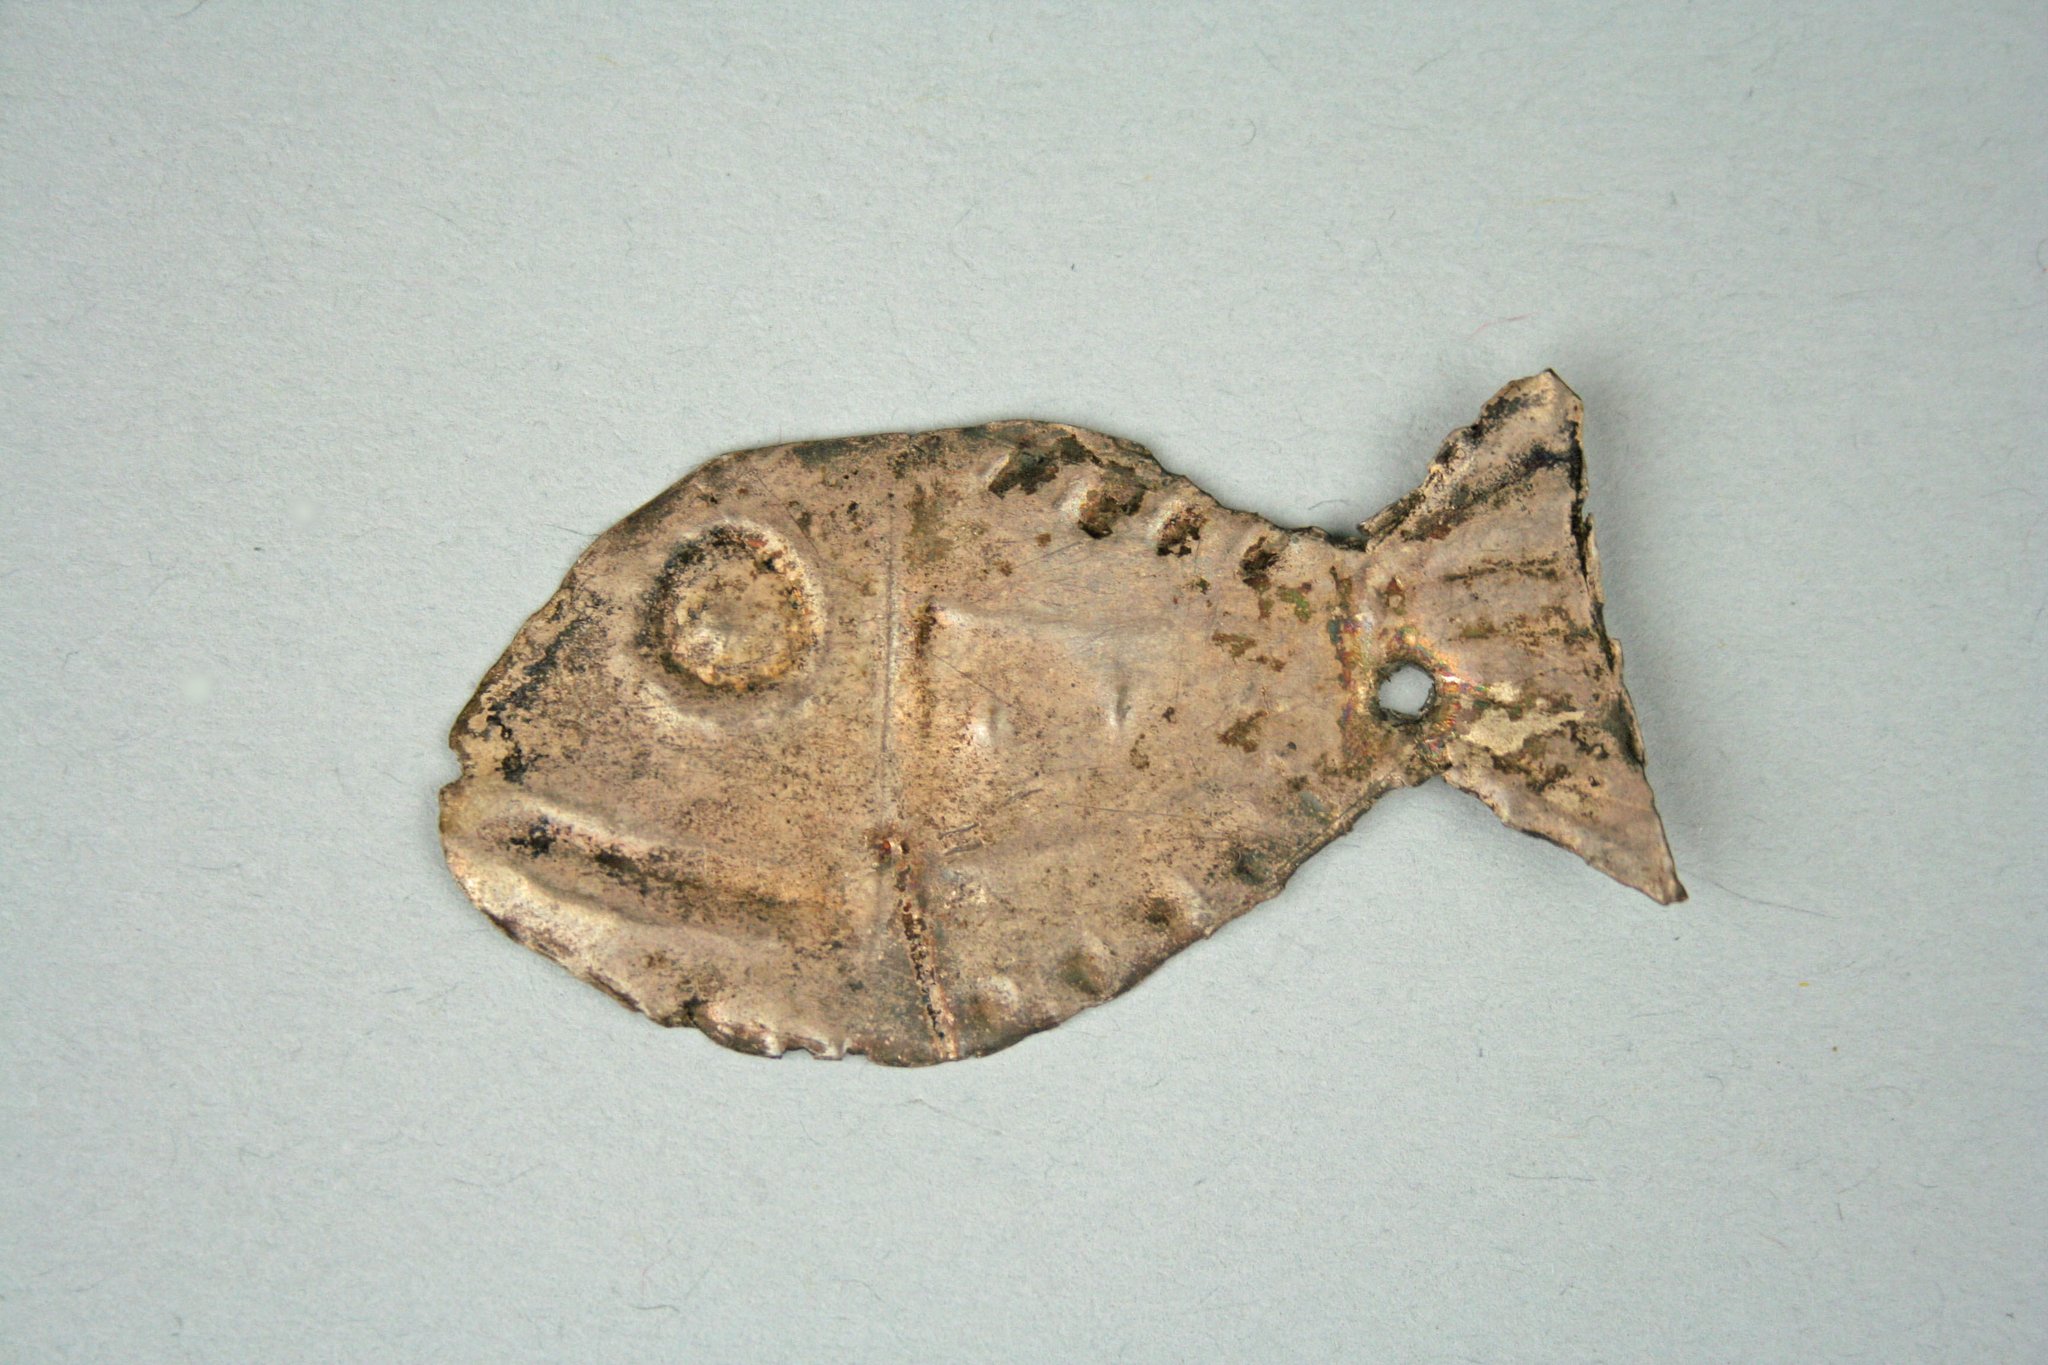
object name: ornament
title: Fish Ornament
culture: peruvian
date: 1001-1200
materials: silver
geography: peru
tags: fish